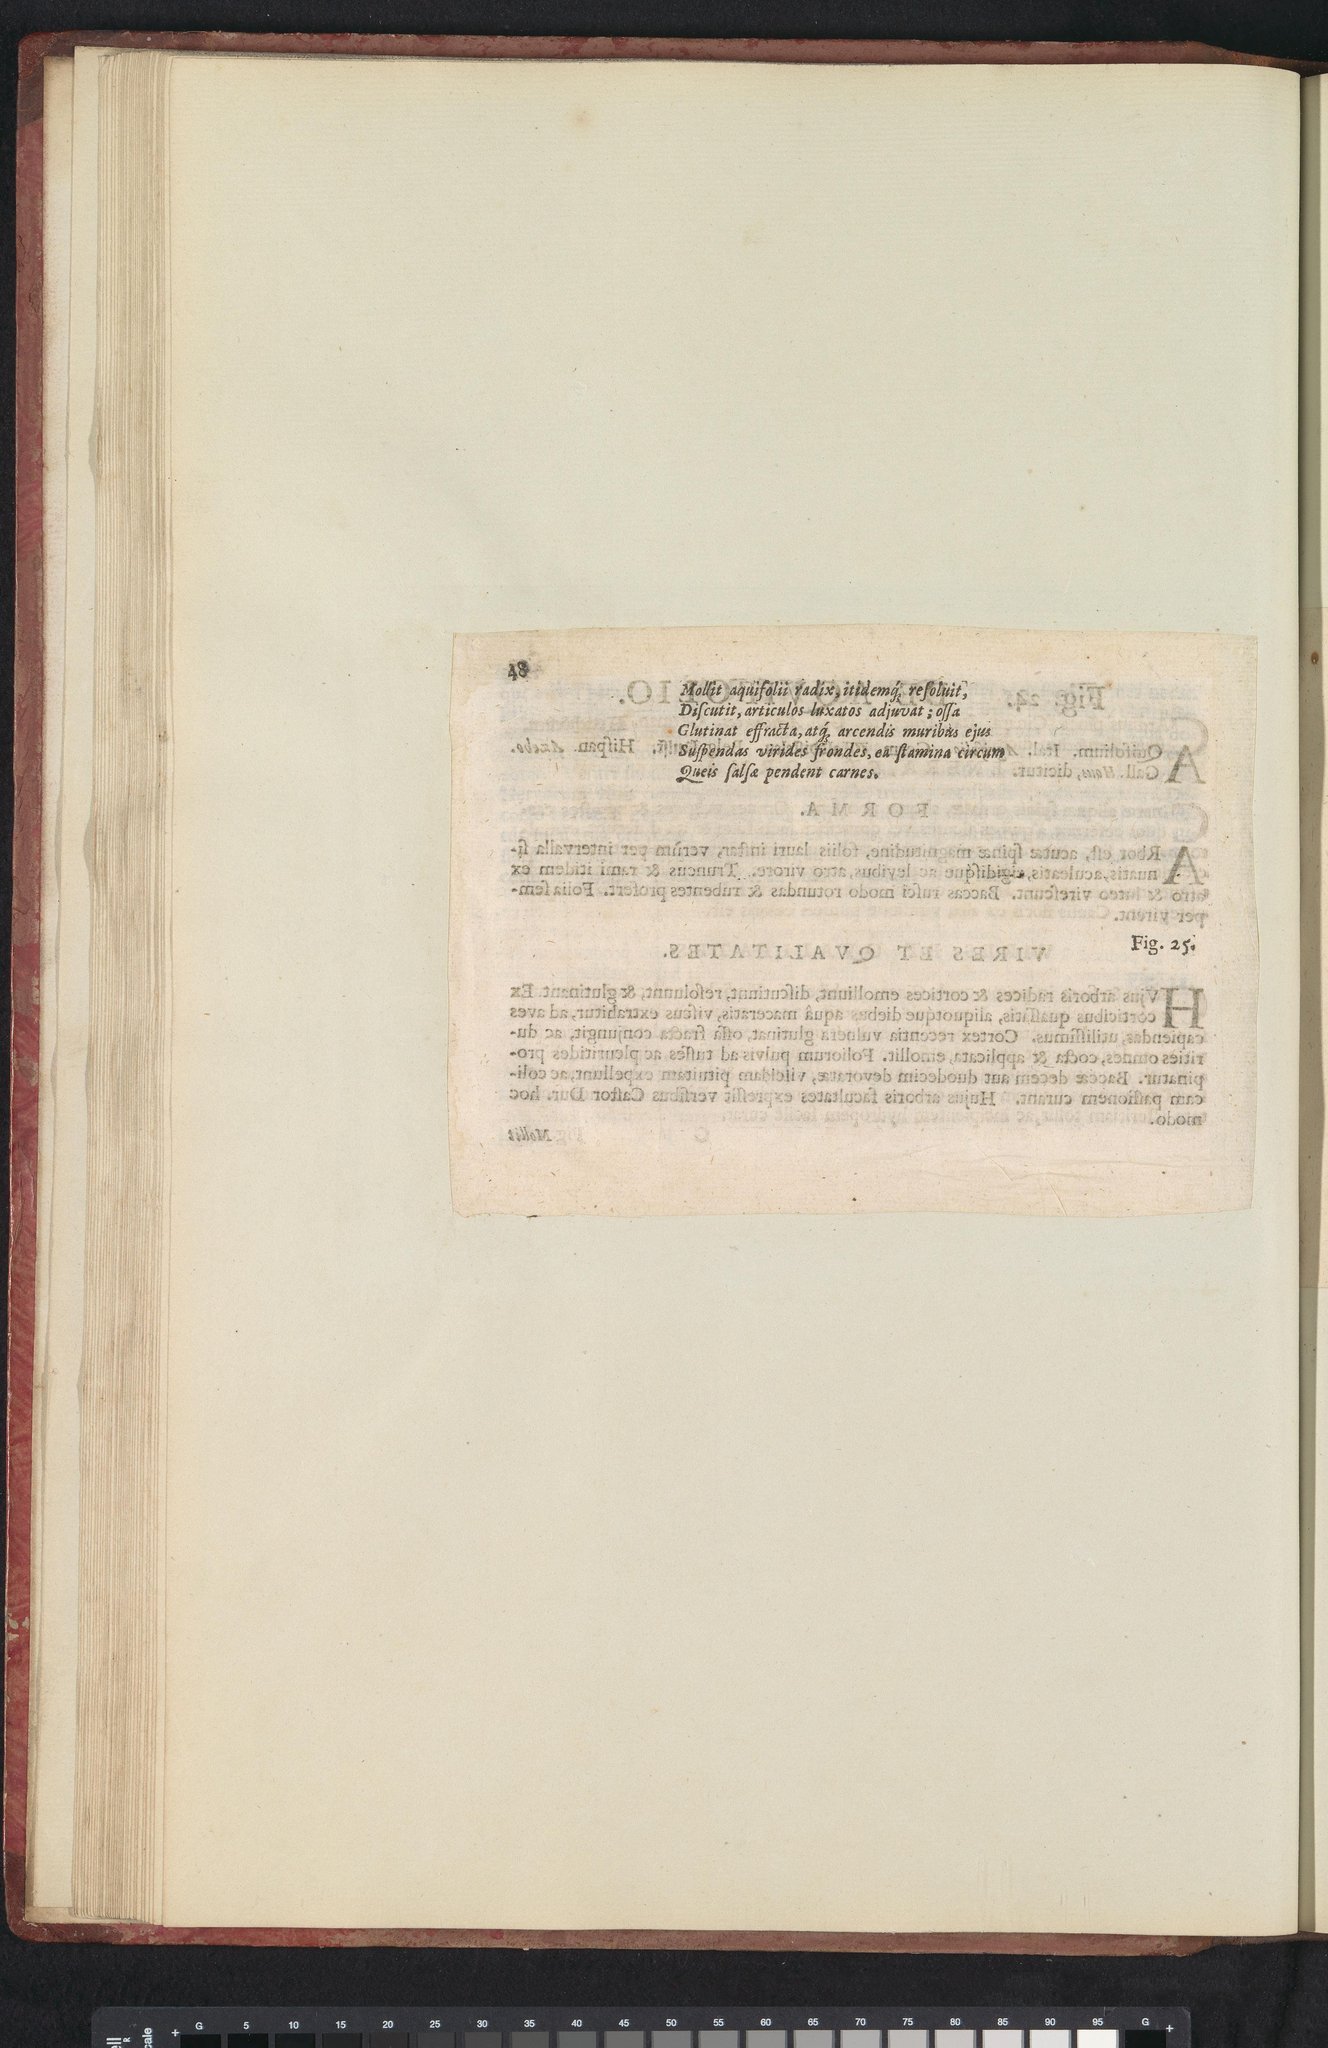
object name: text sheet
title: Fig. 24 'De Aqvifolio' in De Boodts herbarium van 1640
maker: anselmus boëtius de boodt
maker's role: draughtsman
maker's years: 1550-1632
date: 1640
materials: ink, paper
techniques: letterpress printing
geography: bruges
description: Beschrijving bij Fig. 24 op p. 48 in: Anselmi Boëtii de Boot I.C. Brugensis & Rodolphi II. Imp. Roman. medici a cubiculis Florum, Herbarum, ac fructuum selectiorum icones, & vires pleraeque hactenus ignotæ. Onderdeel van het album met bladen en platen uit De Boodts herbarium van 1640. Het twaalfde van twaalf albums met aquarellen van dieren, vogels en planten bekend rond 1600, gemaakt in opdracht van keizer Rudolf II.